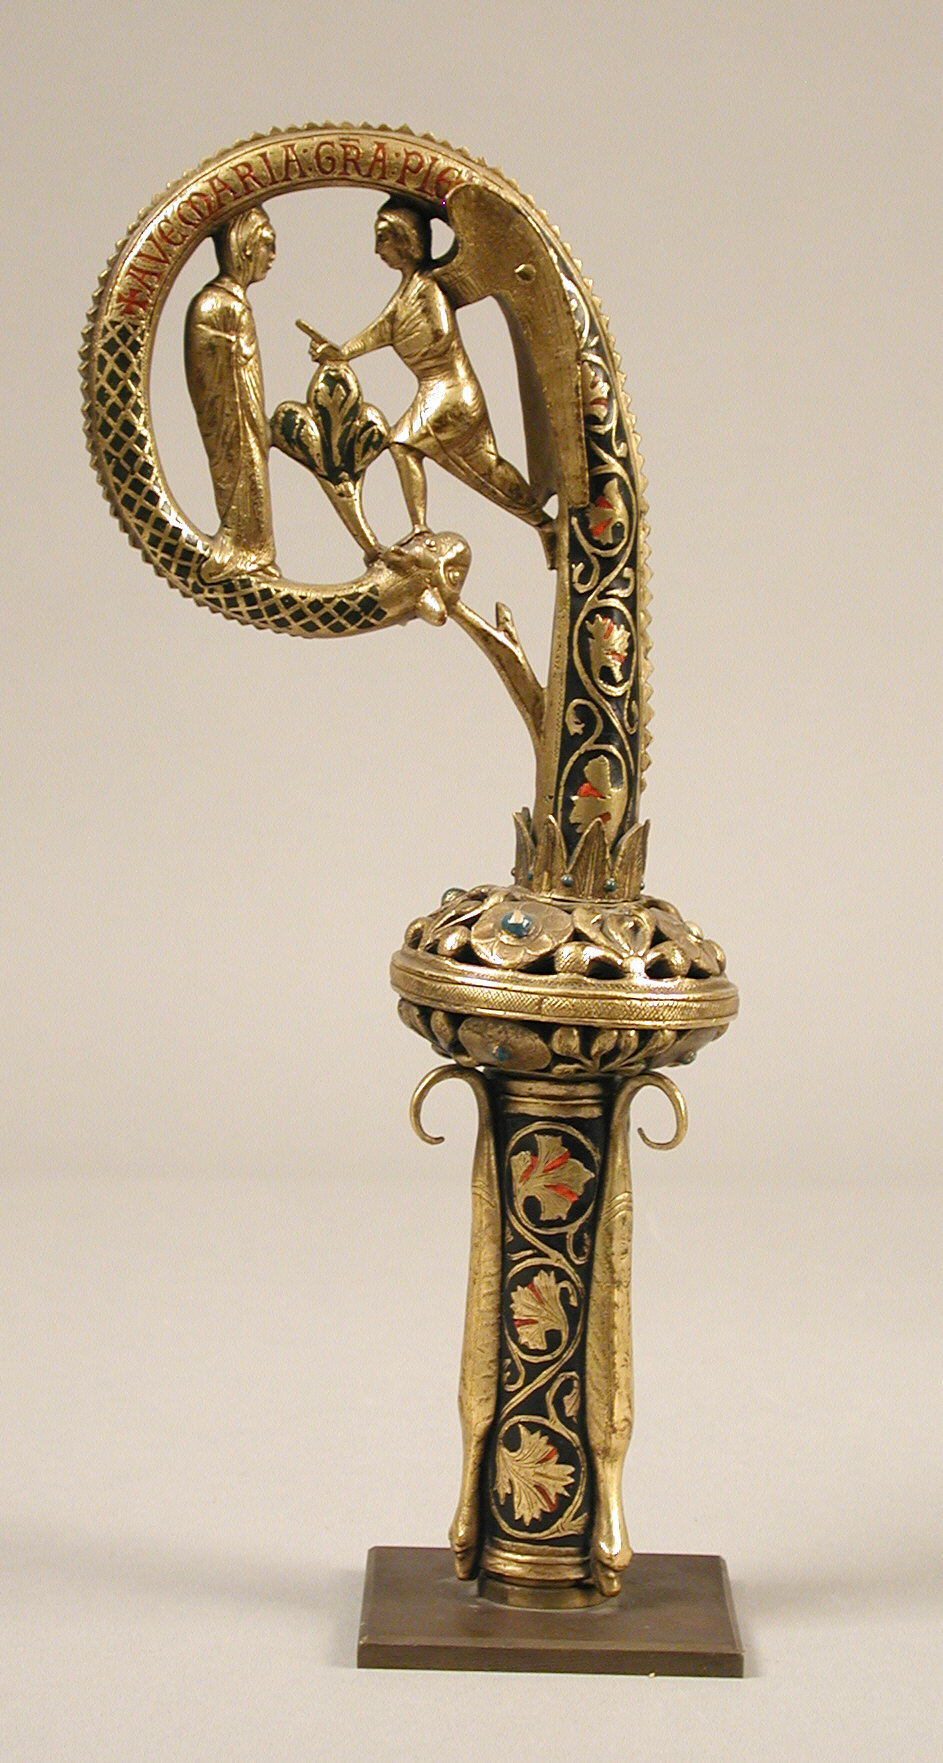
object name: crozier head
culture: french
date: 1901-1933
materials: gilt copper, enamel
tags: human figures